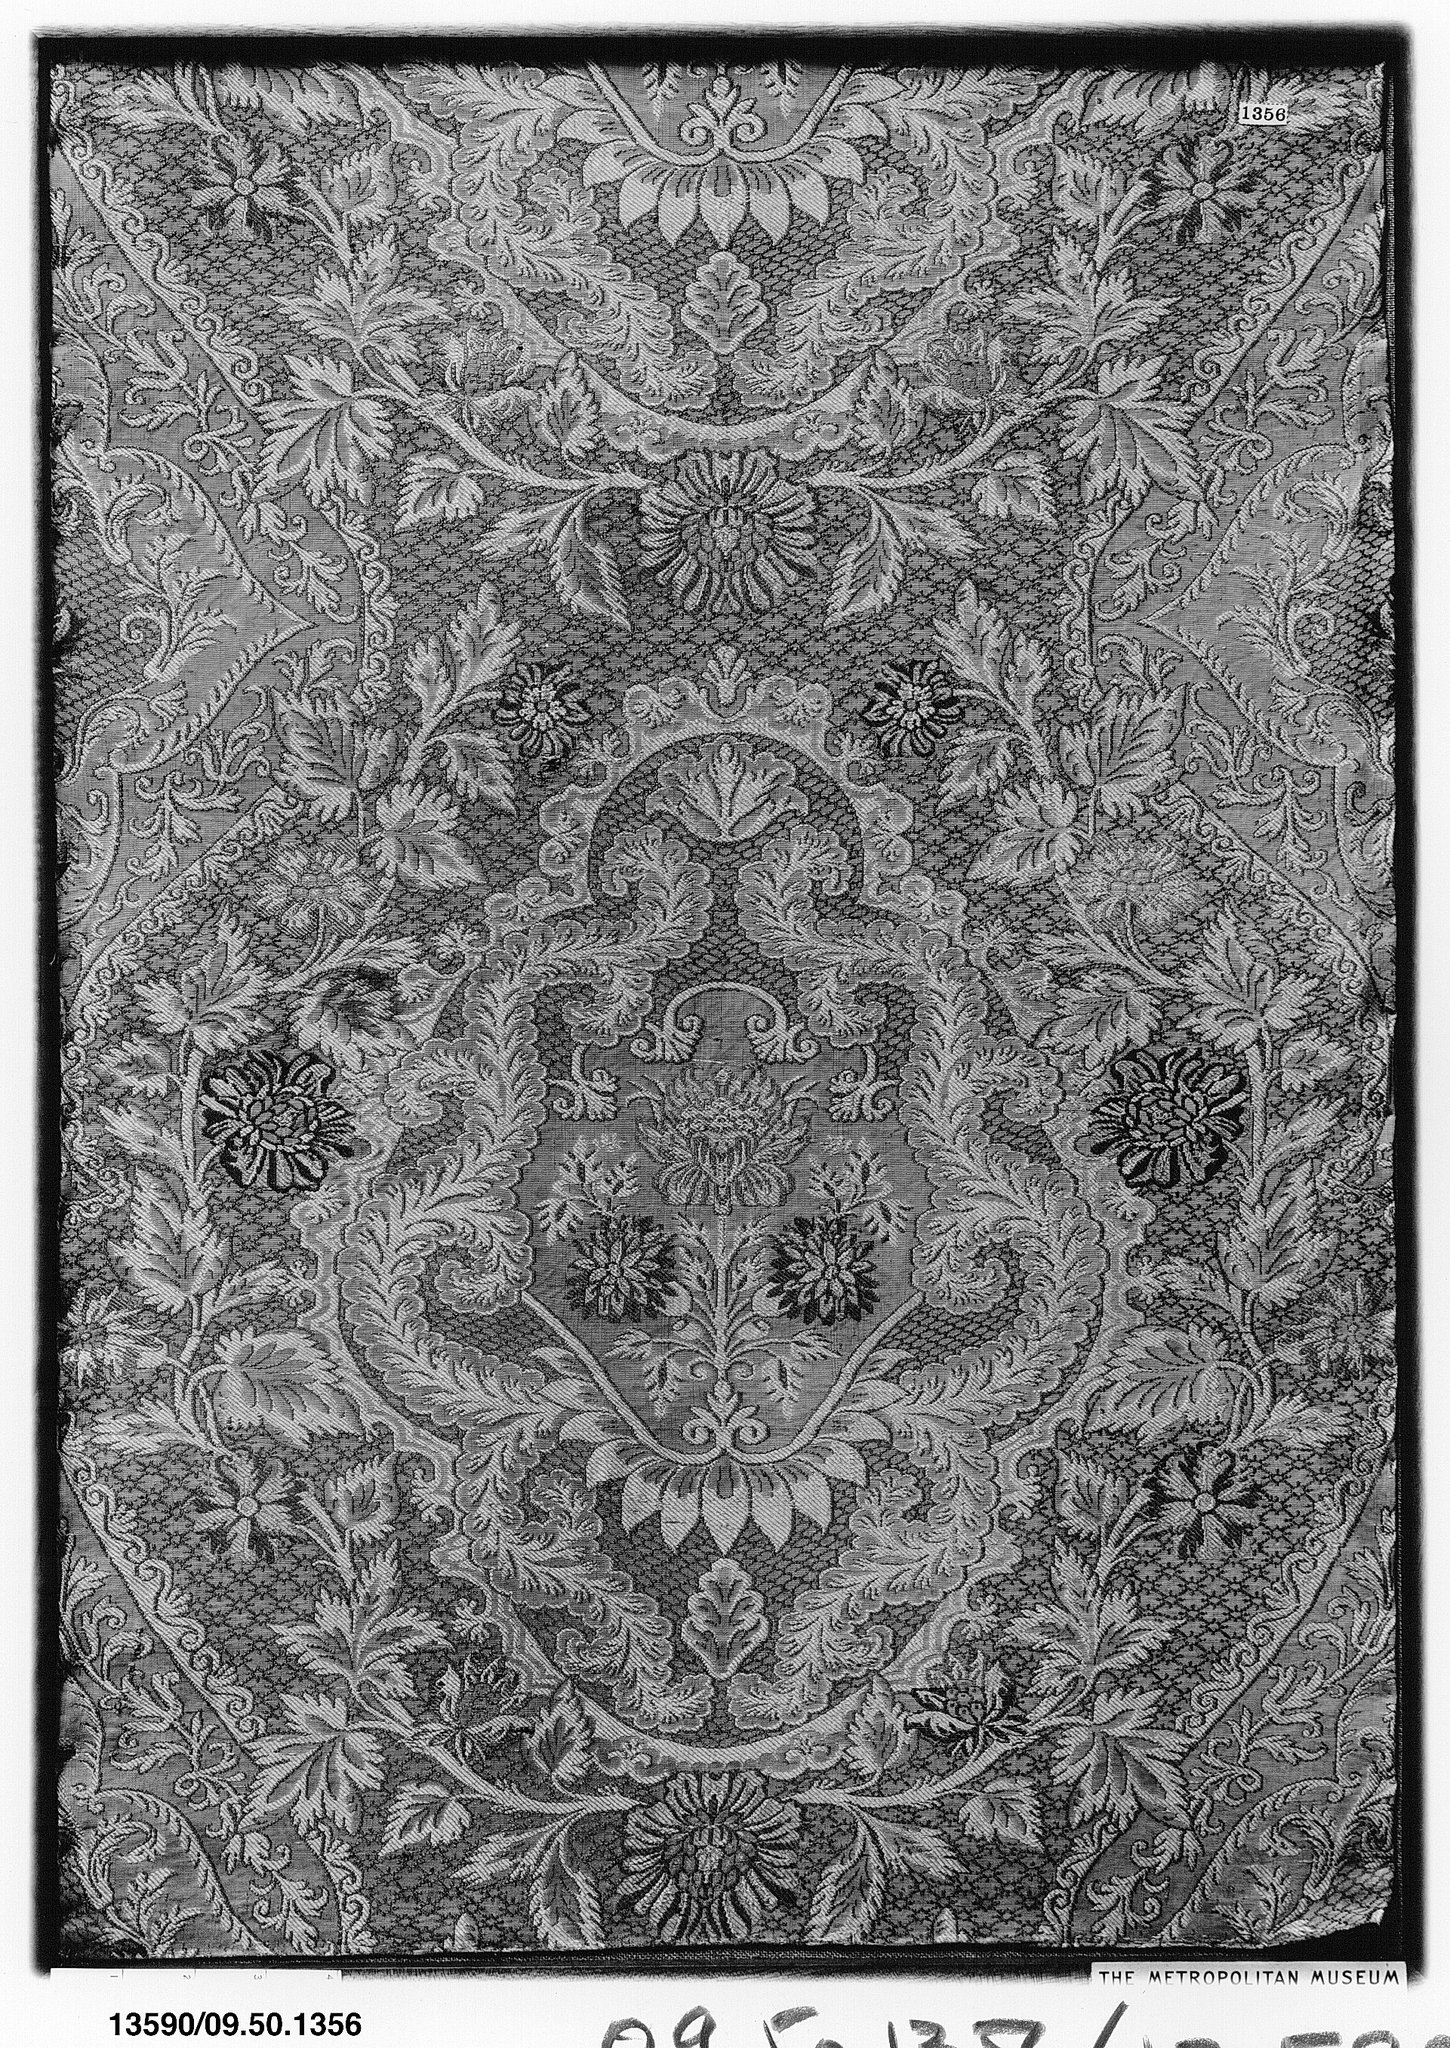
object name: piece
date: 1720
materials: silk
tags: flowers,leaves